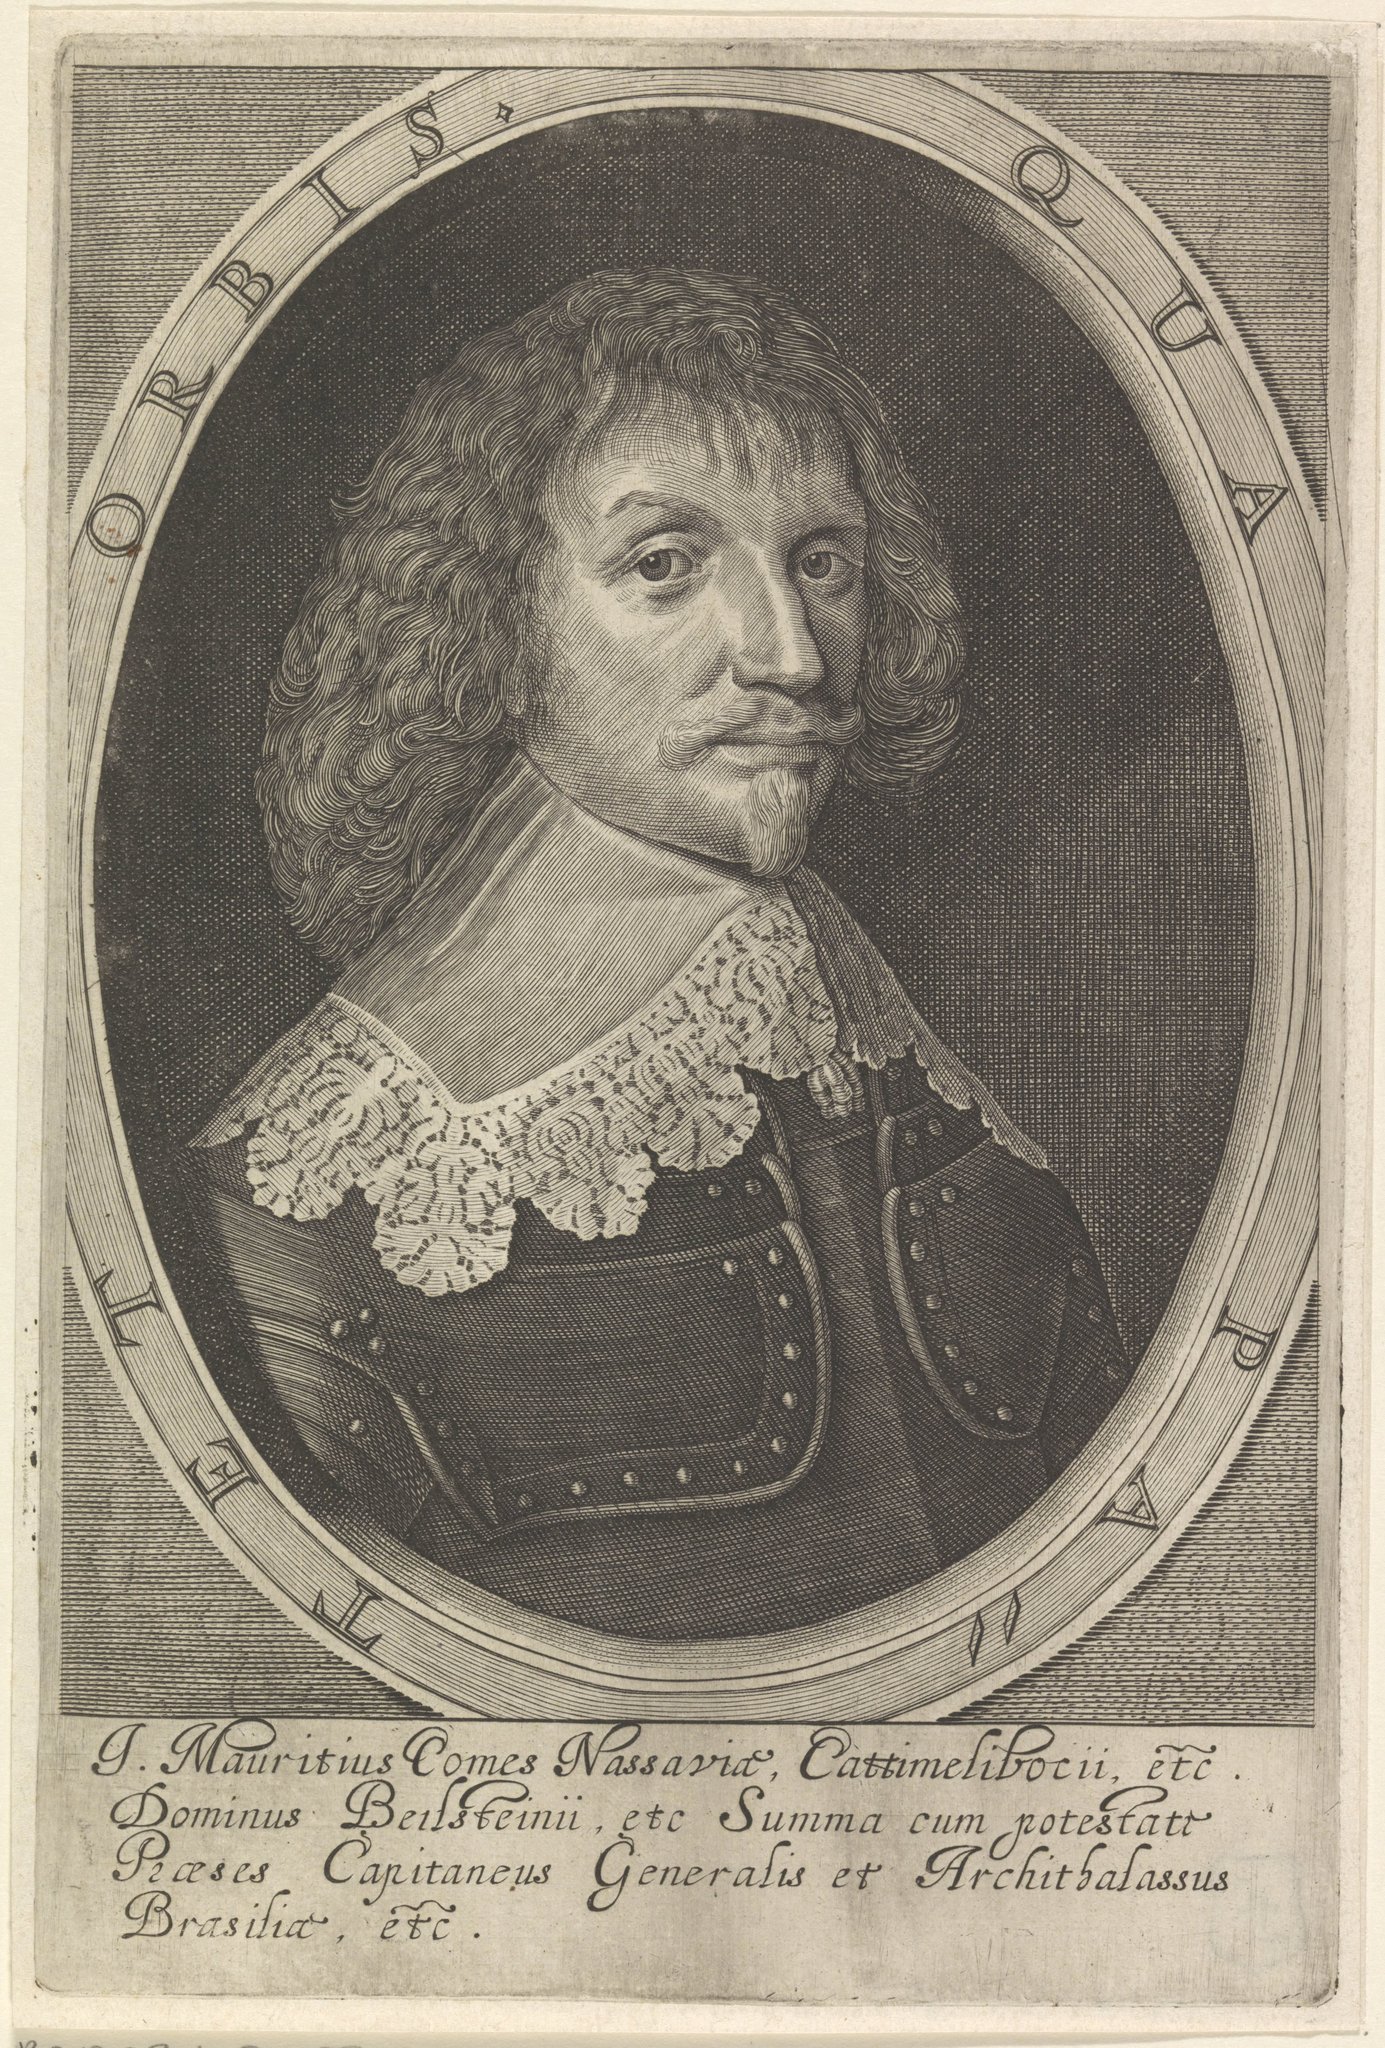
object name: print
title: Portret van Johan Maurits, graaf van Nassau-Siegen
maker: Anonymous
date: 1625-1699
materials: paper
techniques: engraving, etching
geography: low countries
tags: earl, johan maurits graaf van nassau-siegen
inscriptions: collector's mark: Lugt 963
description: De hier vermelde titel verwijst naar de hoogst verkregen titel van de geportretteerde, niet per se naar de titel die de geportretteerde op deze voorstelling draagt.